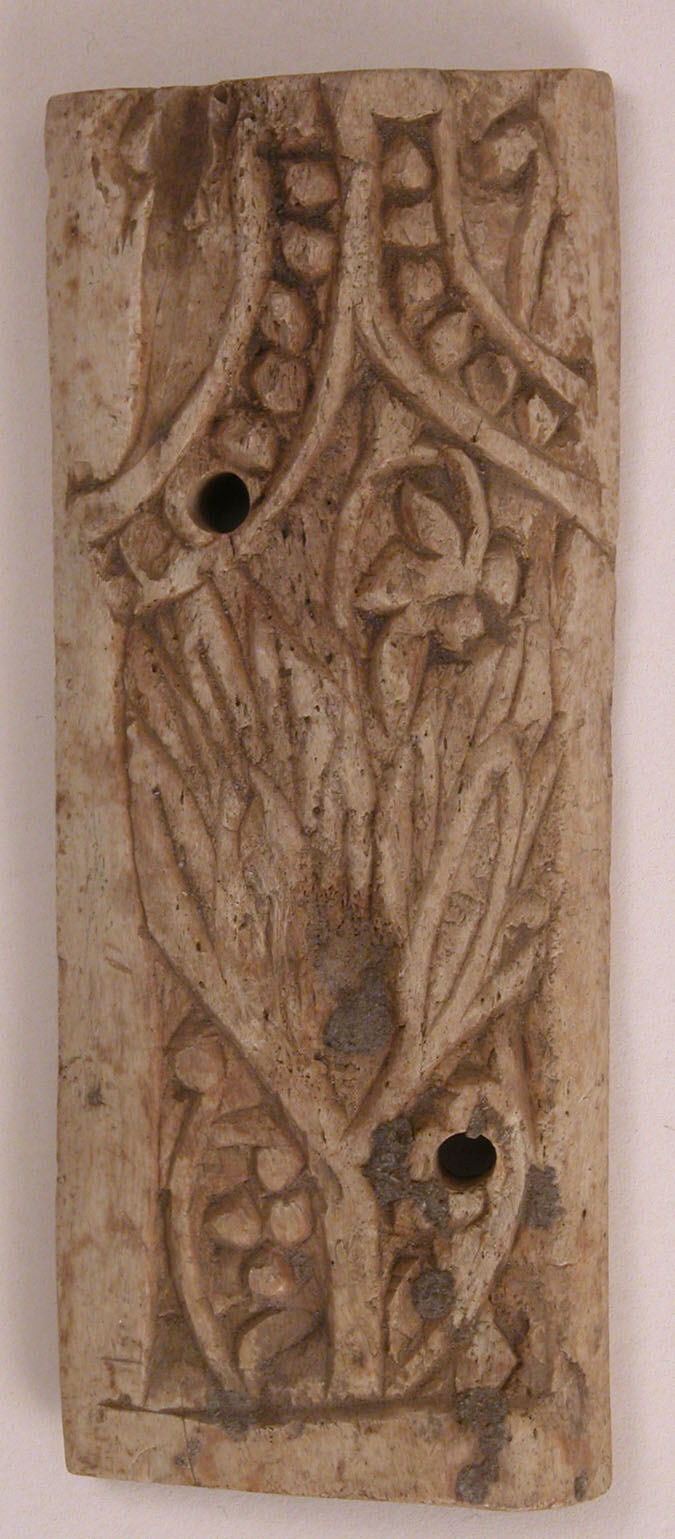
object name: plaque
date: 501-700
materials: bone, paint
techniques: carving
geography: egypt